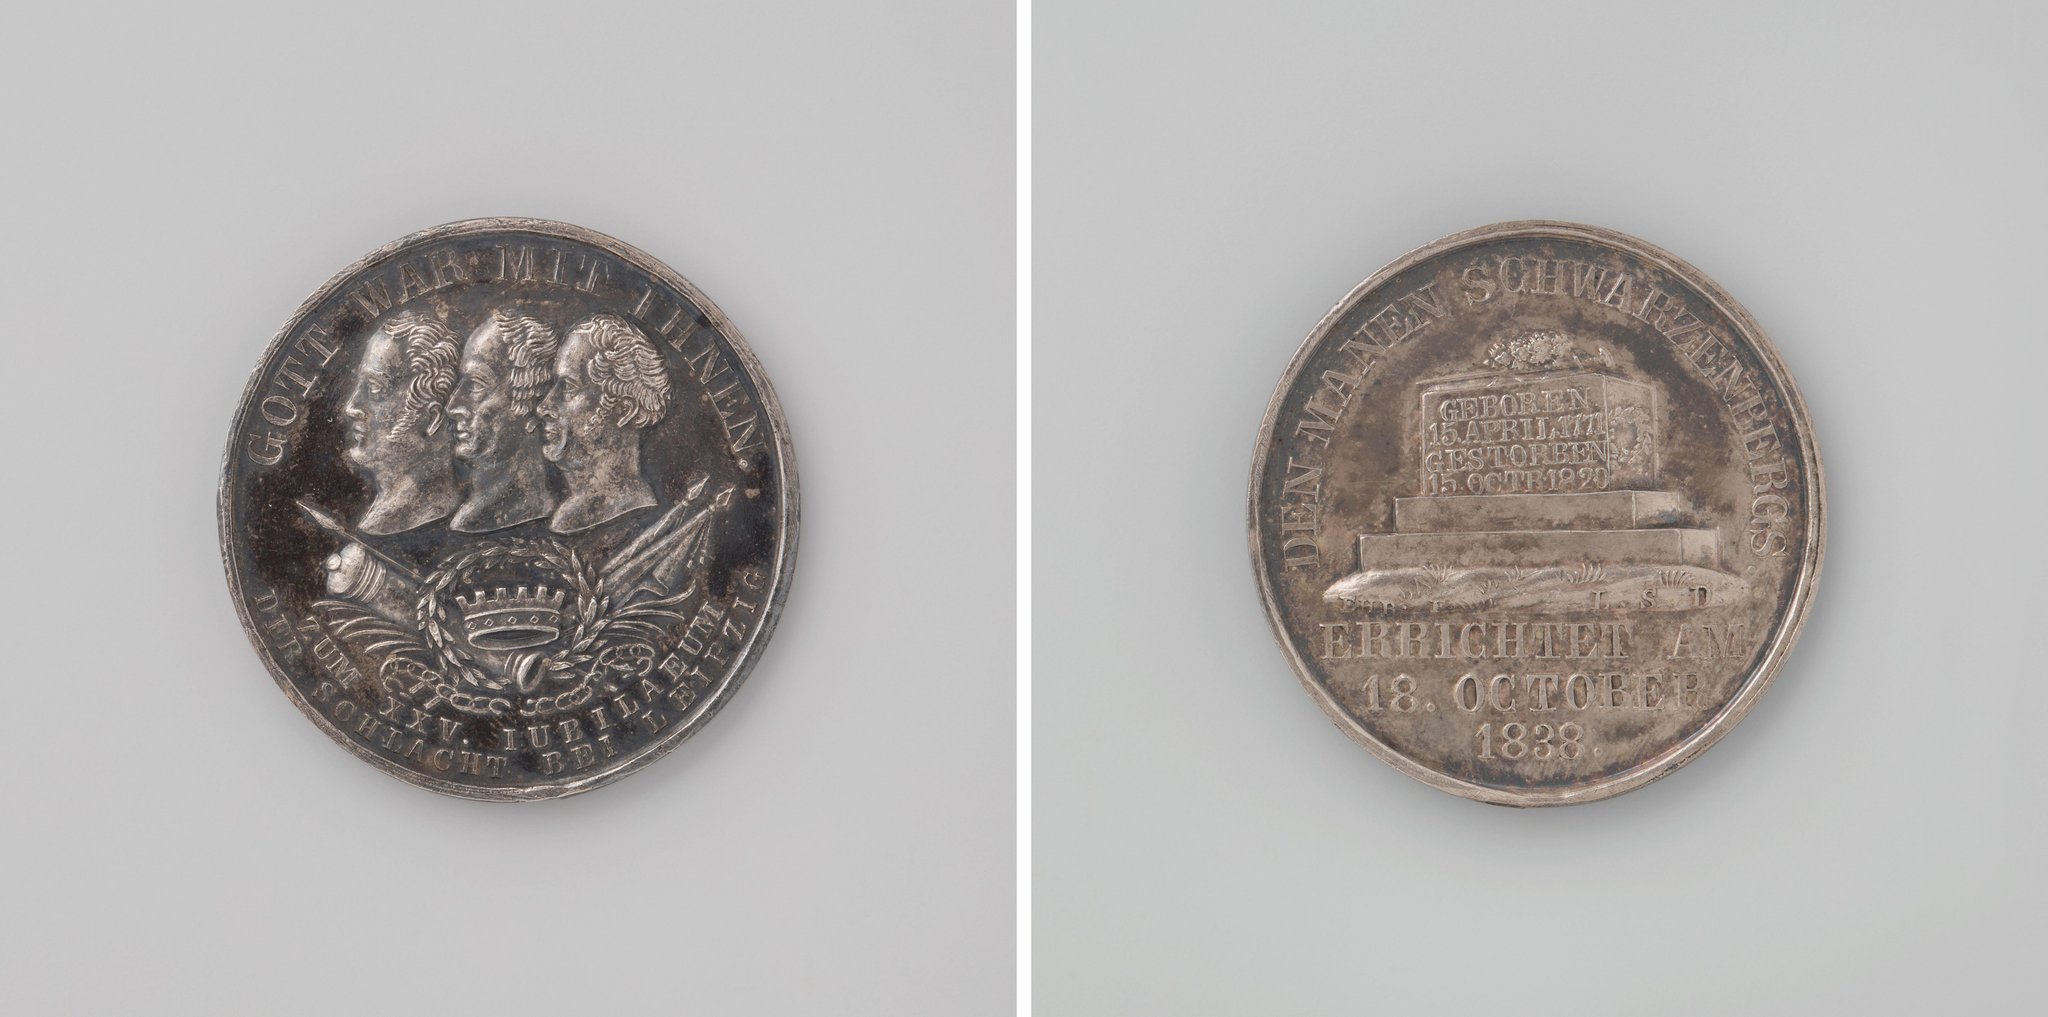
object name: history medal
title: Oprichting van een monument voor Carl Philipp von Schwarzenberg, ter herdenking van de slag bij Leipzig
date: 1838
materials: silver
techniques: striking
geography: germany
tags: vienna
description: Zilveren penning. Voorzijde: borststukken van drie mannen boven kroon in lauwerkrans, voor gekruist kanon en vaandels binnen omschrift. Keerzijde: monument met opschrift, waarop lauwerkransen zwaard liggen binnen omschrift; afsnede: opschrift.